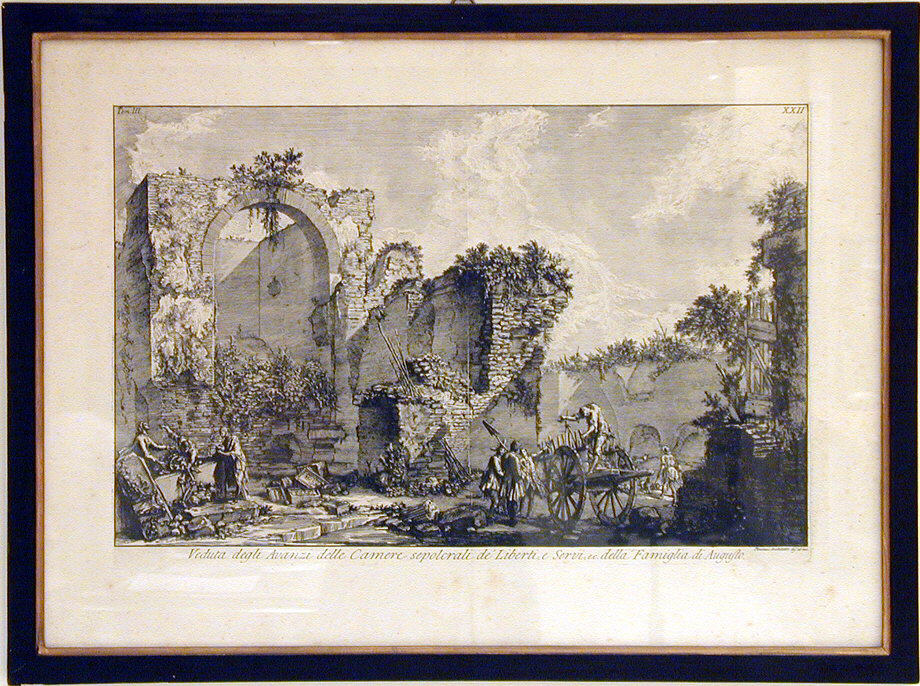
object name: engraving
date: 1701-1800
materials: ink, paper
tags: ruins,maps